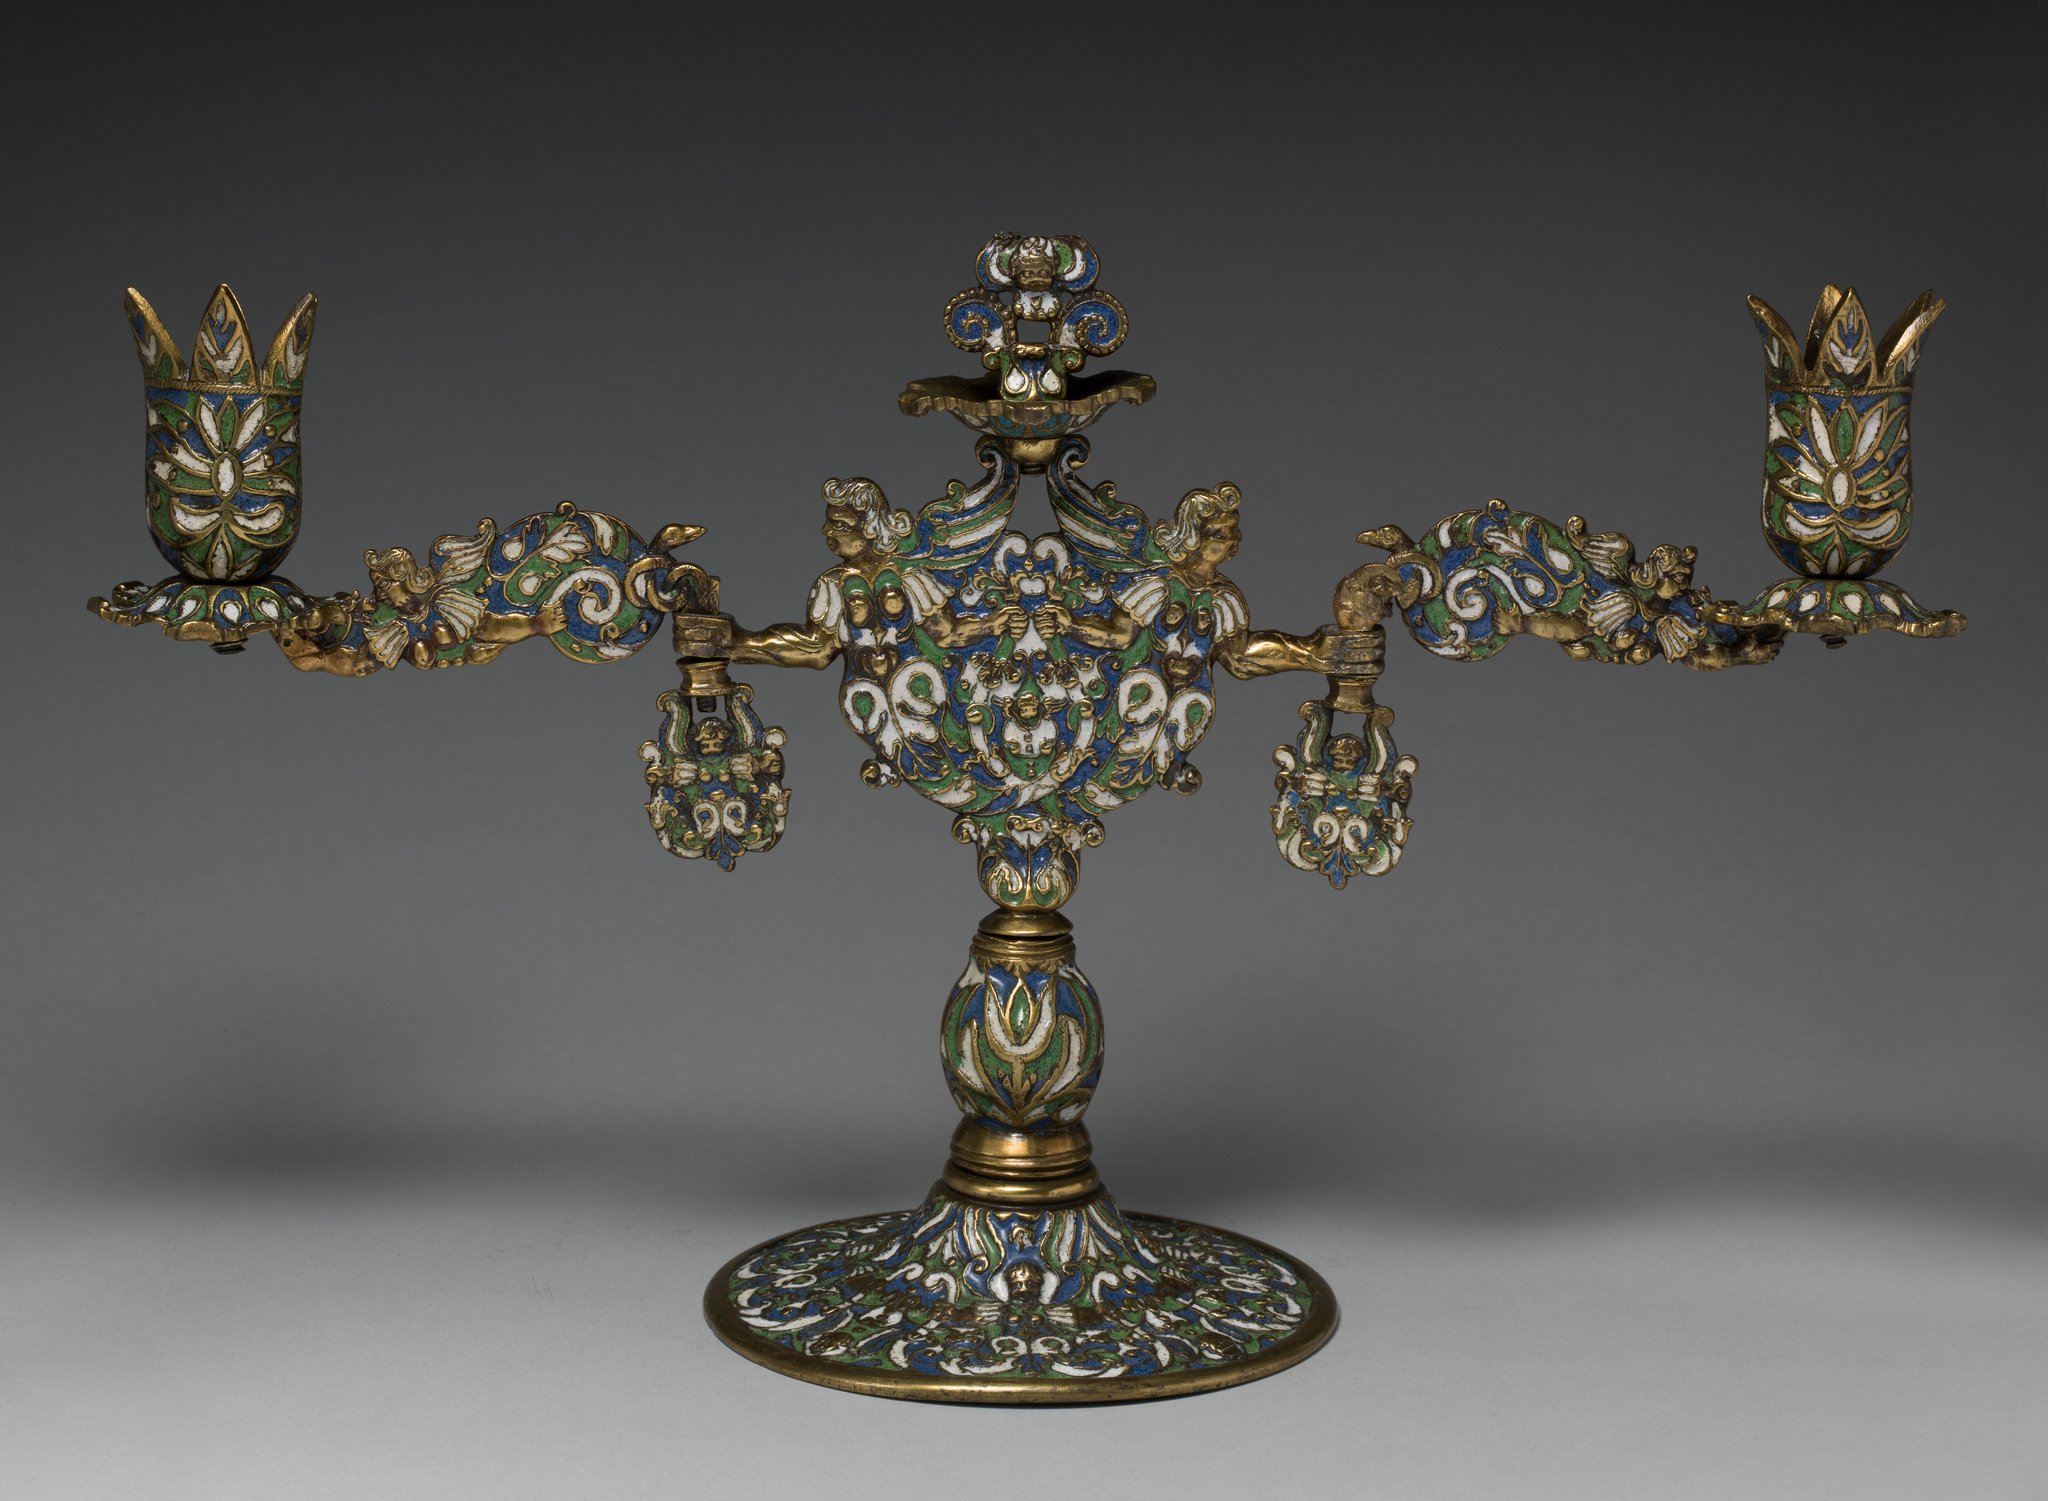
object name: candelabrum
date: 1666-1699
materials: brass, enamel